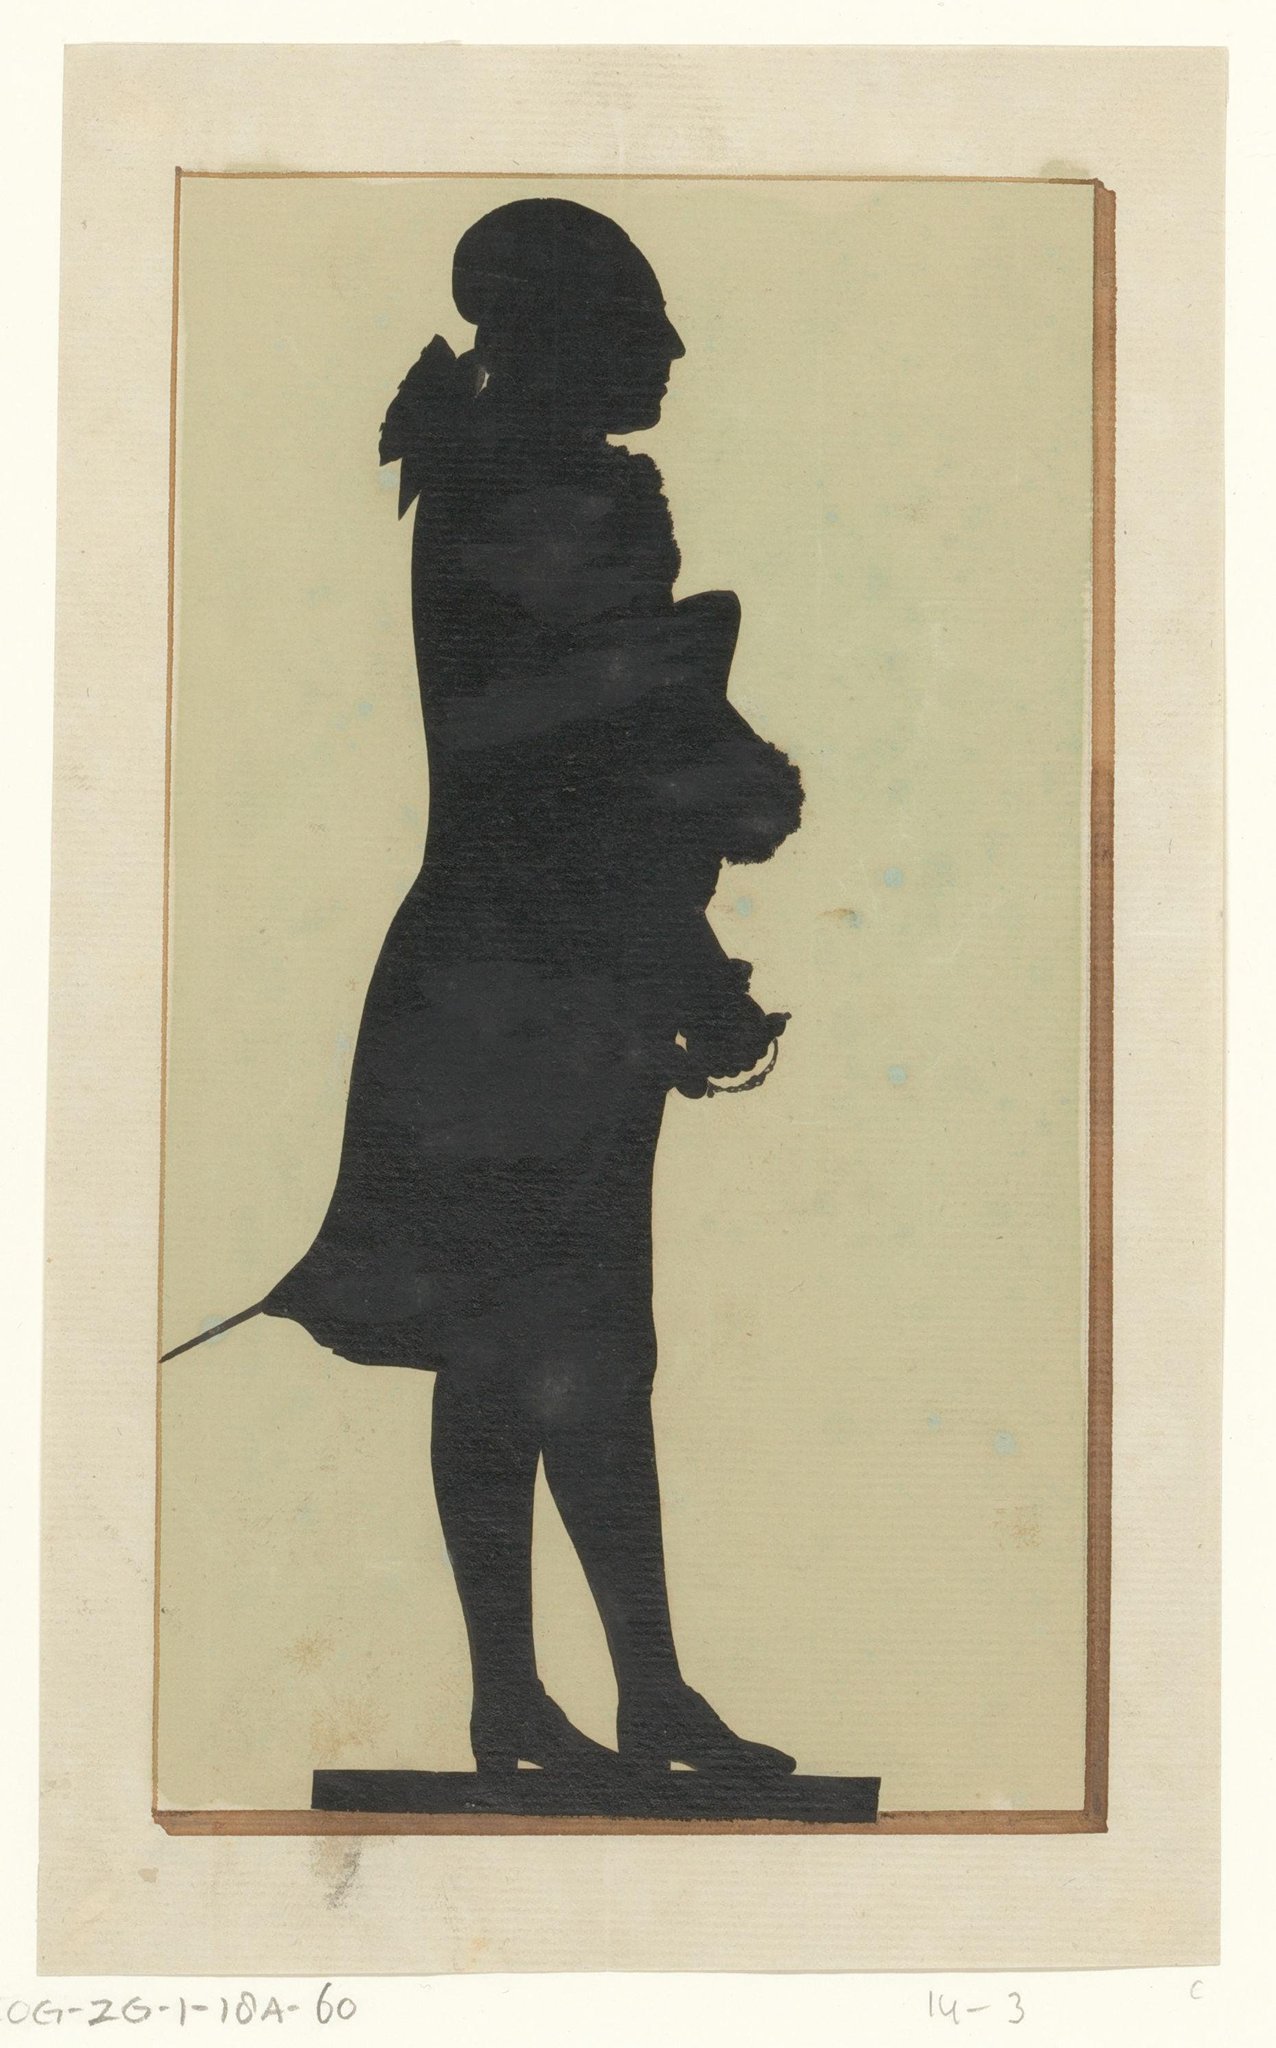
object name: cut paper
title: Silhouetportret van een onbekende staande man met sabel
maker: joseph adolf schmetterling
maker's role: draughtsman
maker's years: 1751-1828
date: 1785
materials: paint, paper, pencil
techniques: brush, snipping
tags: standing figure, hacking and thrusting weapons: rapier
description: Een staande heer met pruik met staart en strik, gekleed in een knielange jas. Zijn rechterhand heeft hij aan het gevest van zijn degen. Met zijn linkerhand houdt hij zijn hoed tegen zich aan. Onderwerpsrubrieken binnen de Atlas Zeden en Gewoonten: Schoone kunsten, Silhouetportretten.